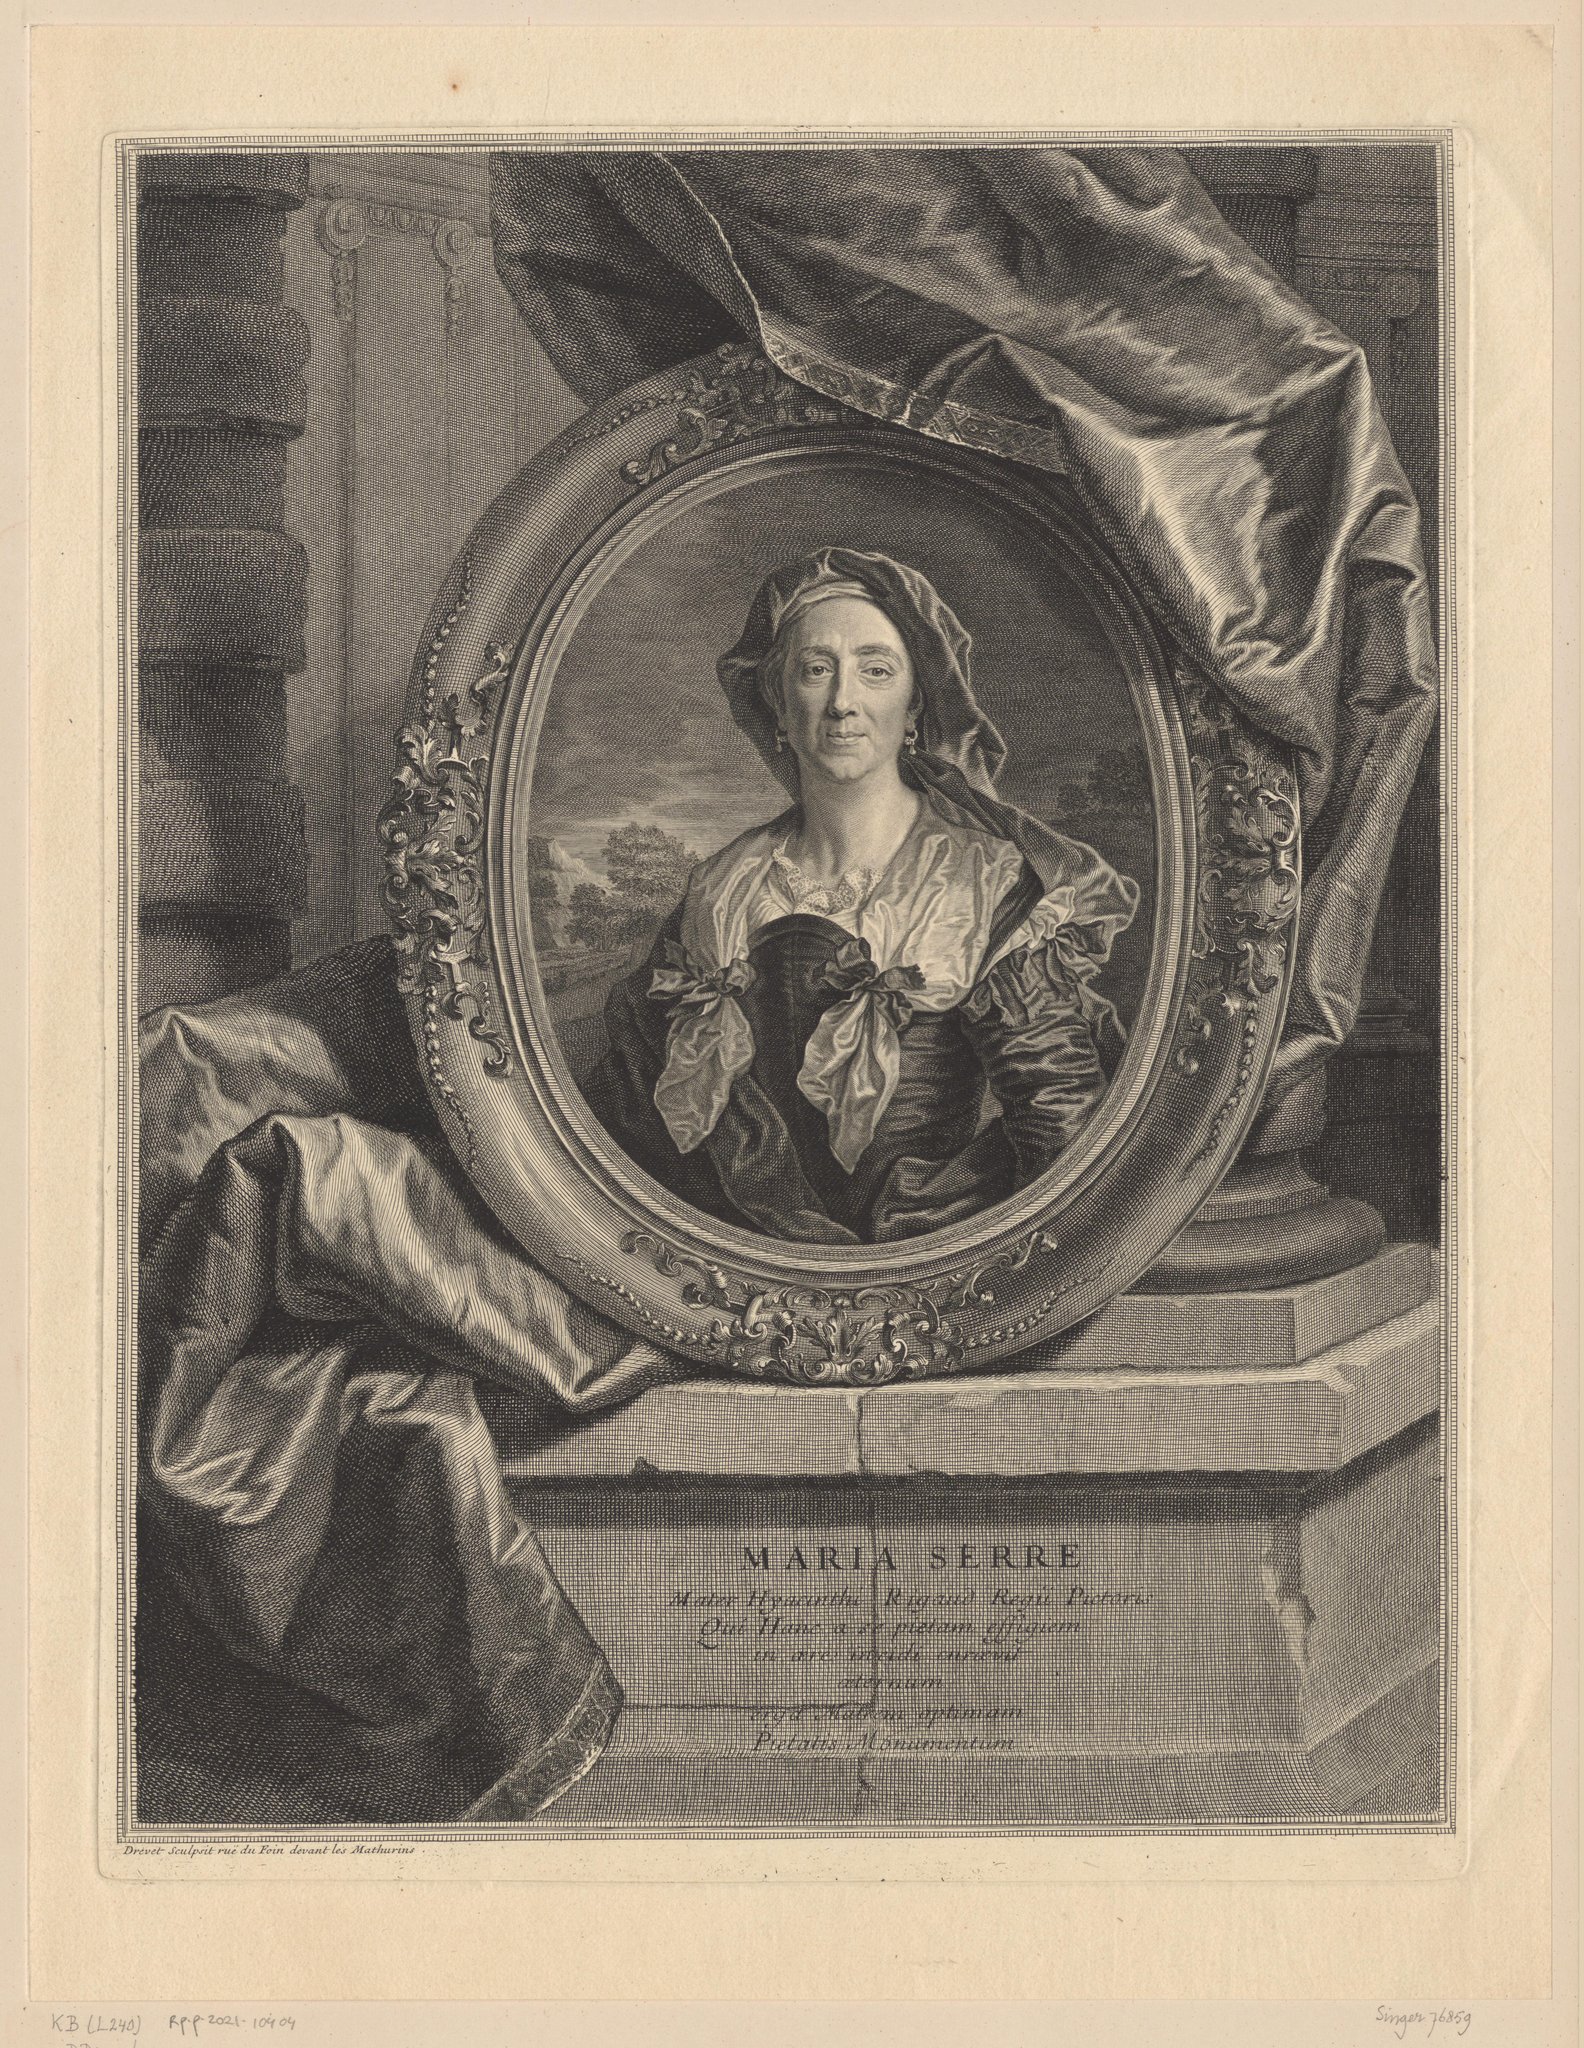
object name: print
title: Maria Serre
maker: pierre drevet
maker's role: print maker, publisher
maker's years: 1663-1738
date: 1702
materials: paper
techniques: engraving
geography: paris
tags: adult woman, historical persons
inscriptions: collector's mark: Lugt 240, inscription: ‘FD 110 II’